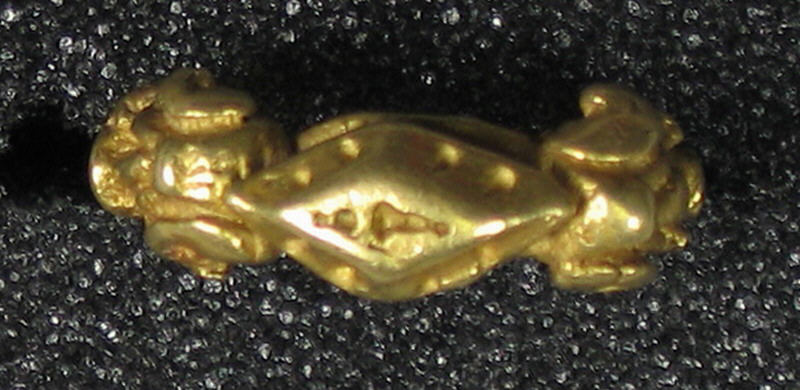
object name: ring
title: Ring with Diamond Bezel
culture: indonesian, central java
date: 701-1200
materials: gold